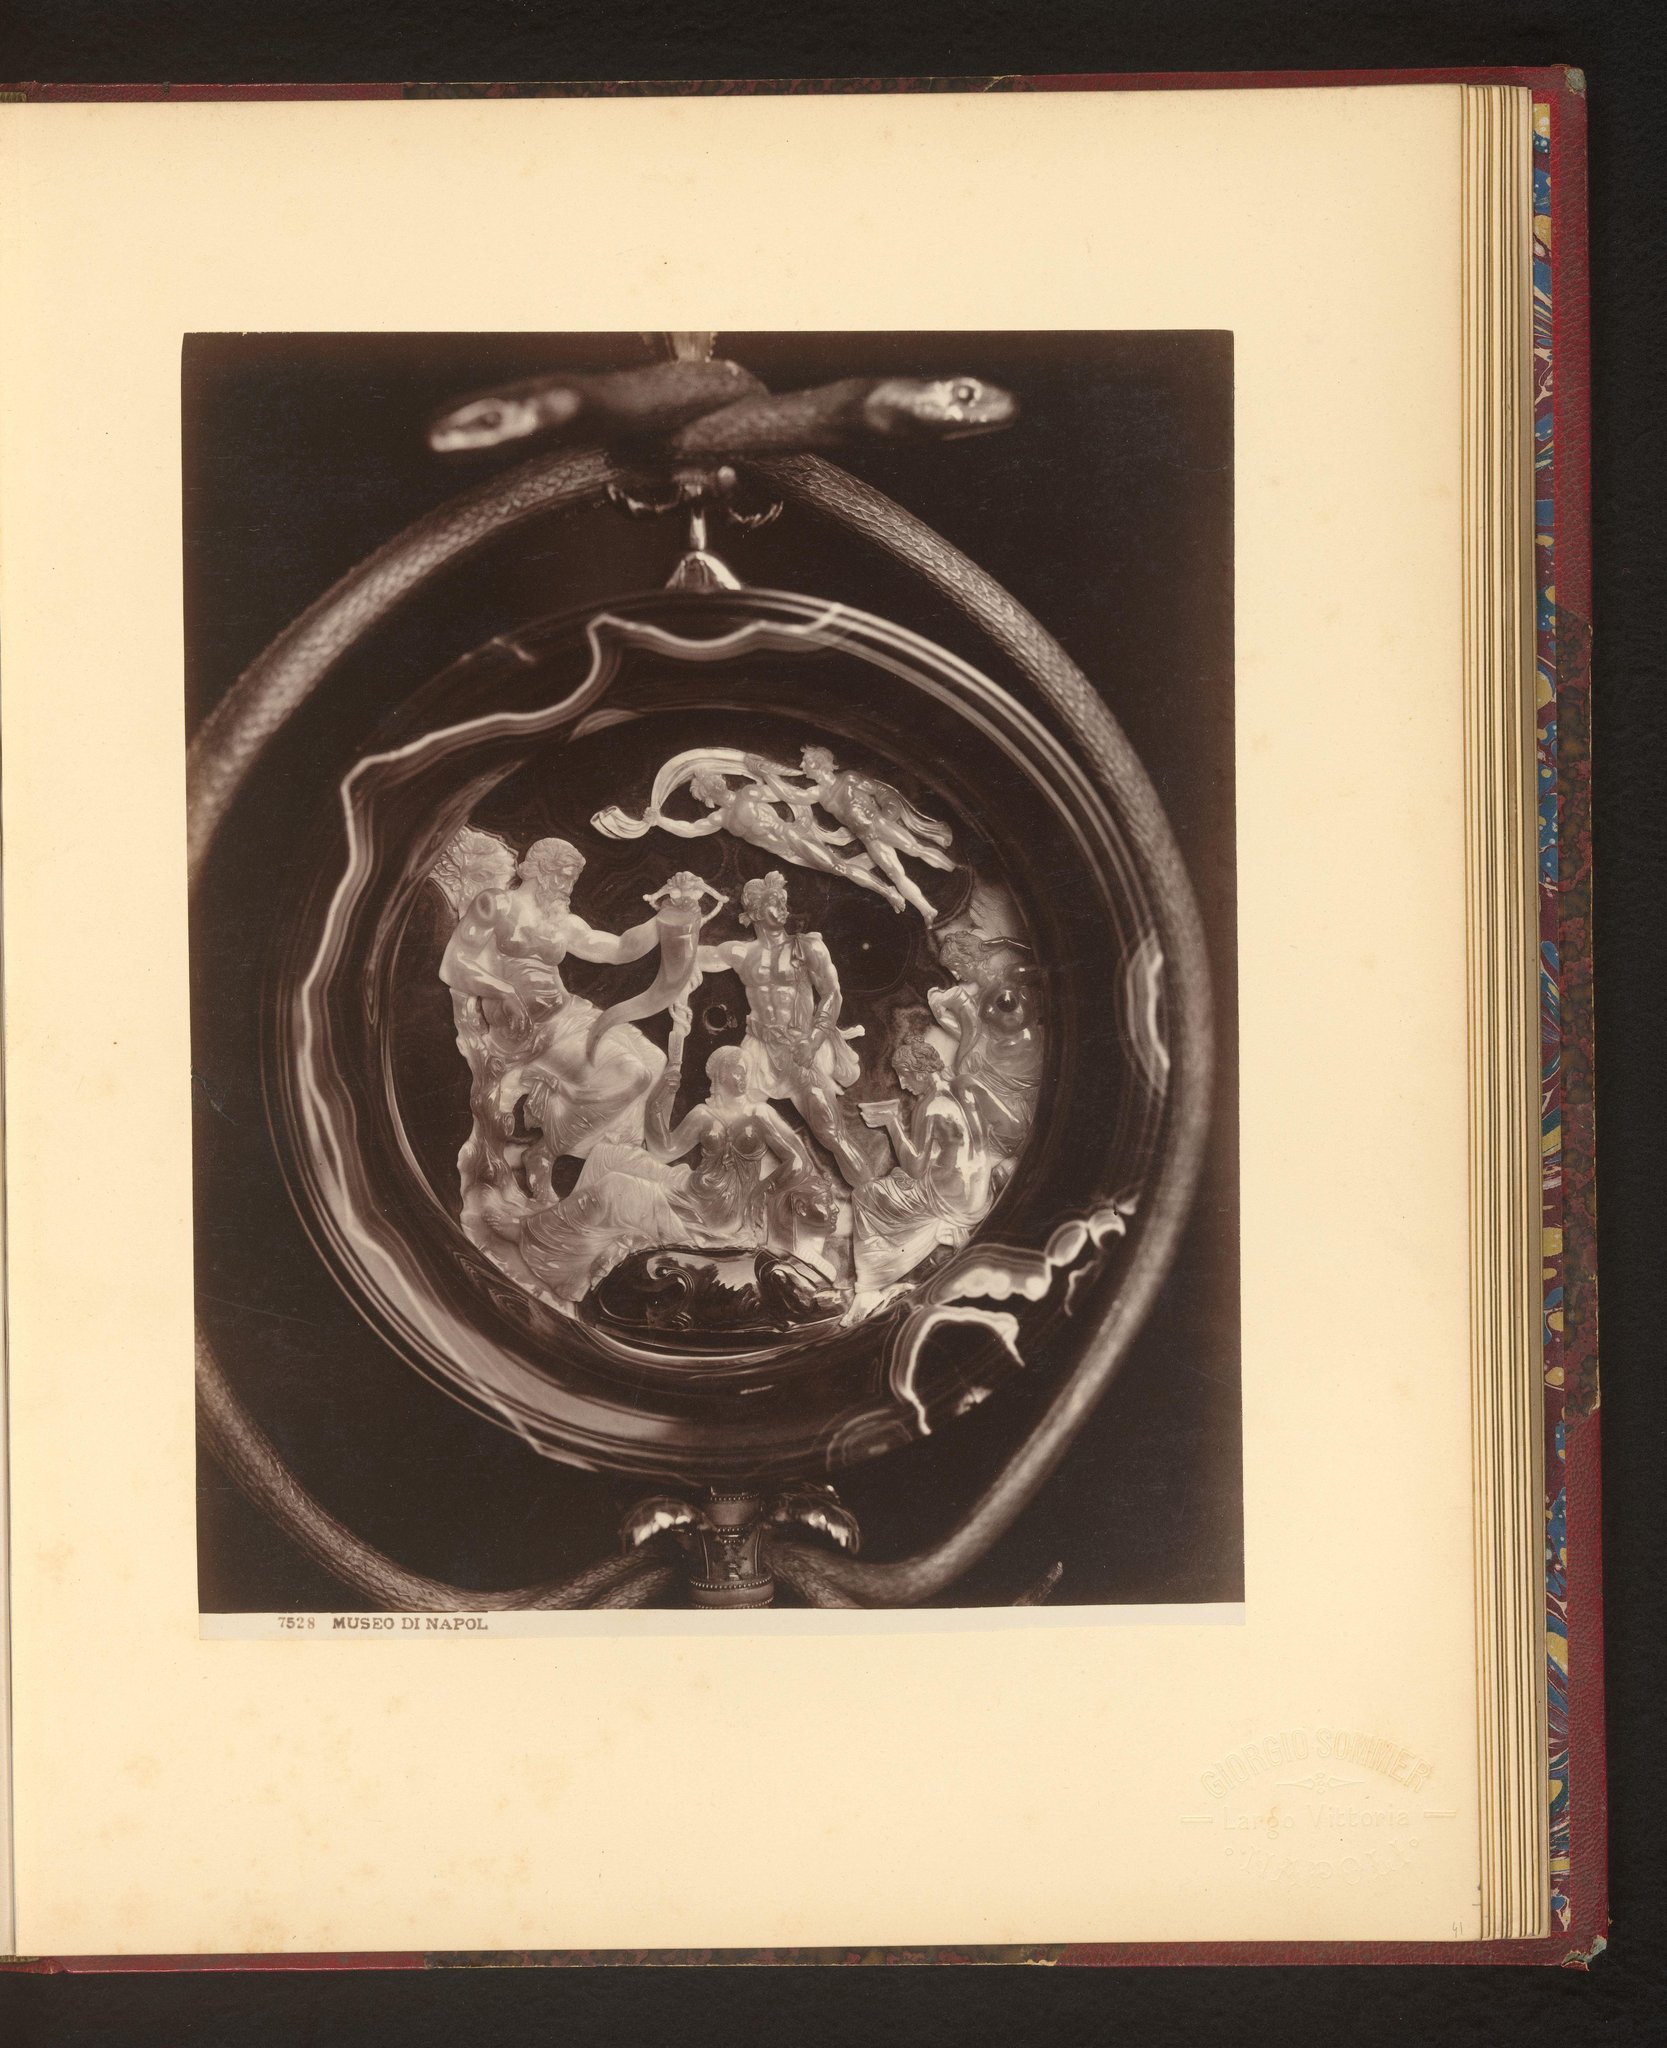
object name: album leaf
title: Museo di Napoli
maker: giorgio sommer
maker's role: fotograaf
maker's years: 1834-1914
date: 1874-1879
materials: photographic support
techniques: albumen print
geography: naples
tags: bowl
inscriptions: number: ‘7528’, workshop stamp: ‘Giorgio Sommer/ Largo Vittoria/ Napoli’